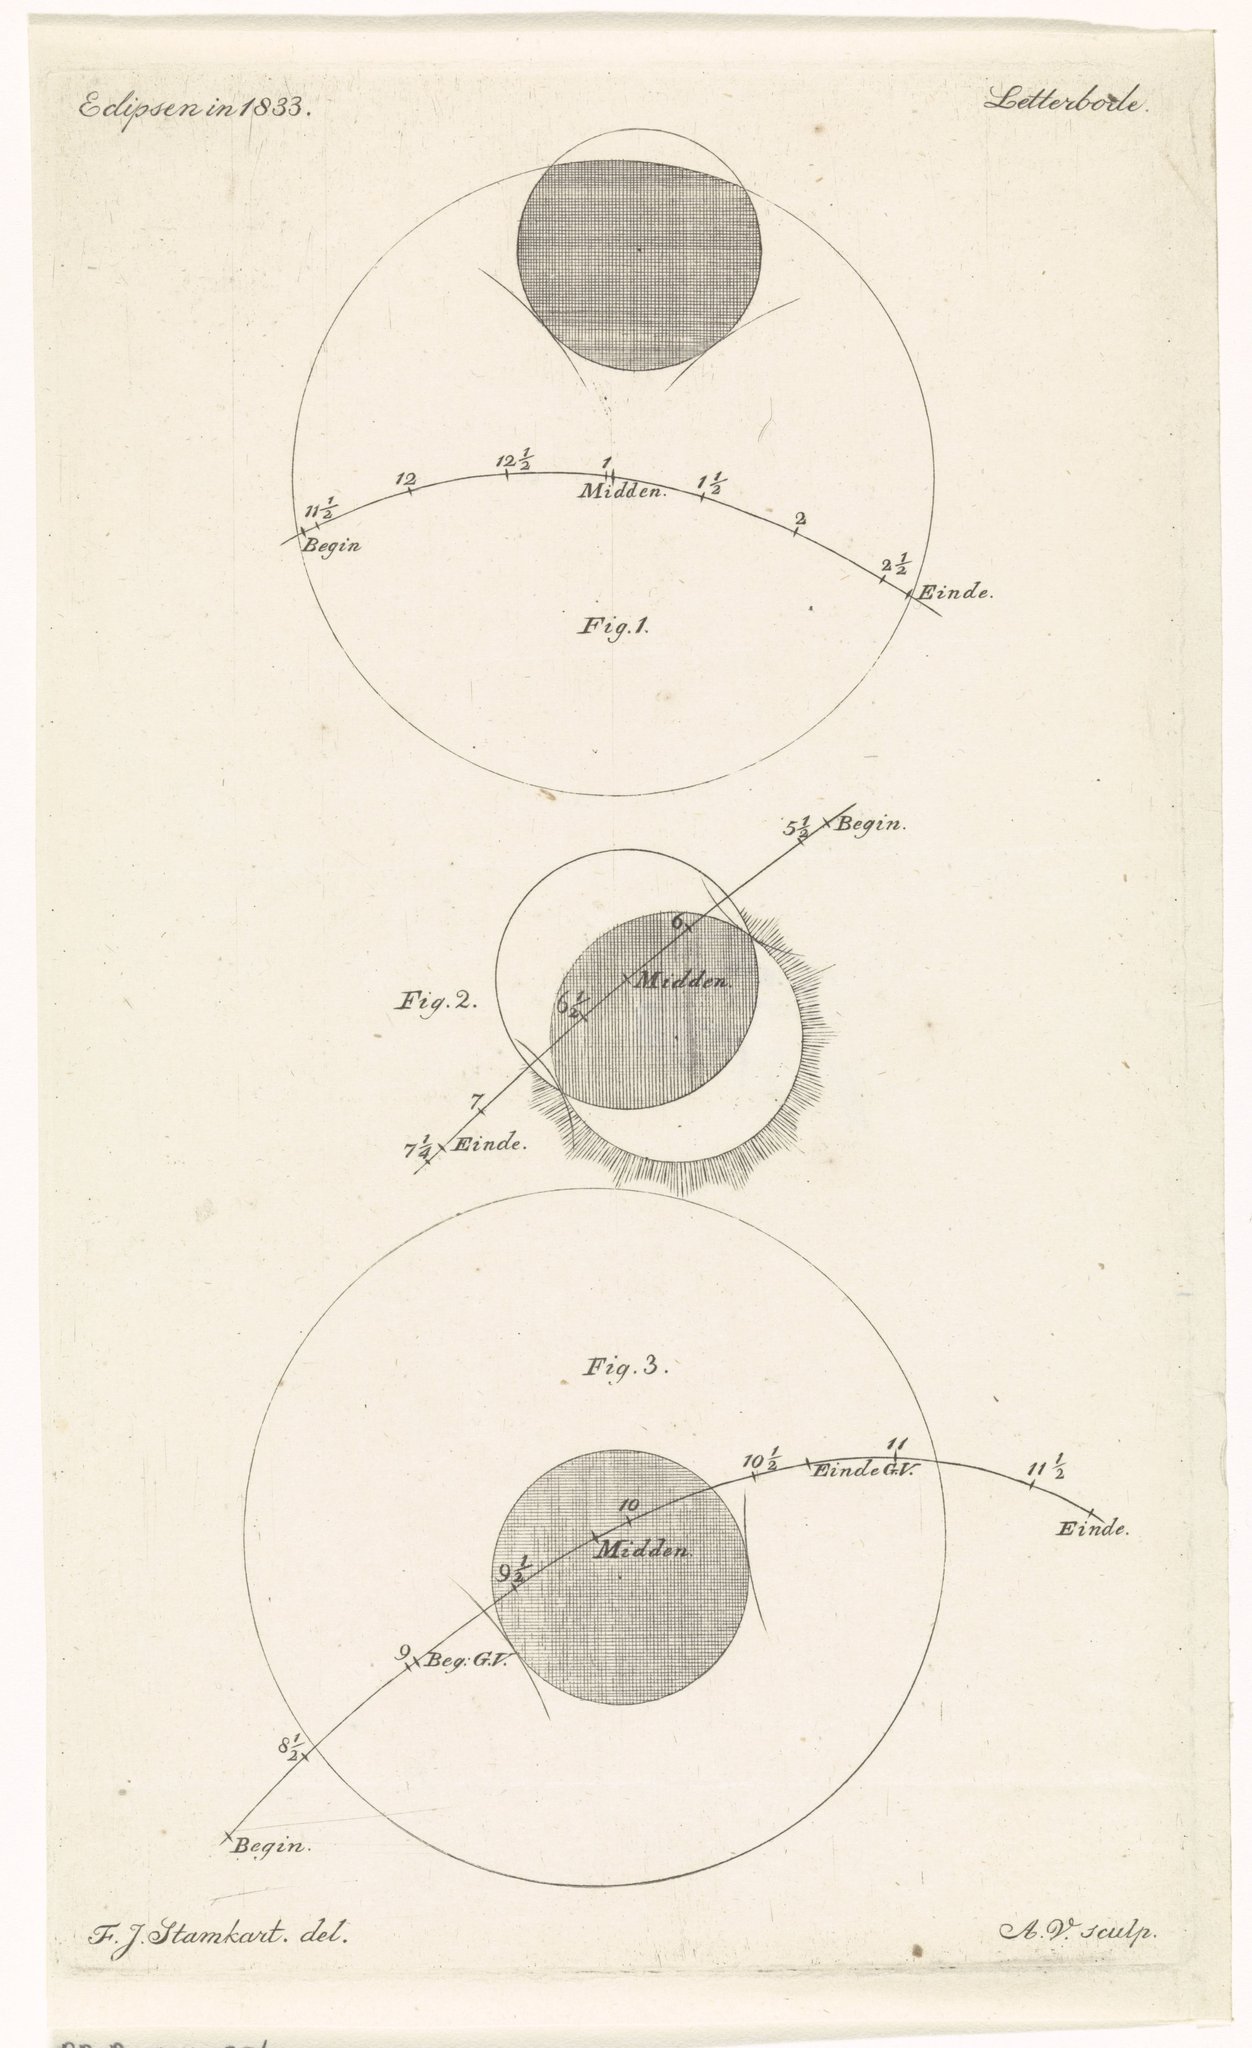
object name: book illustration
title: Eclipsen in 1833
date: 1833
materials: paper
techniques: engraving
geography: haarlem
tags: solar eclipse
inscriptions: collector's mark: Lugt 2228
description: Prent gebruikt als boekillustratie in: Algemeene konst- en letterbode, voor het jaar 1833. Haarlem: A. Loosjes Erven Loosjes, 1833.